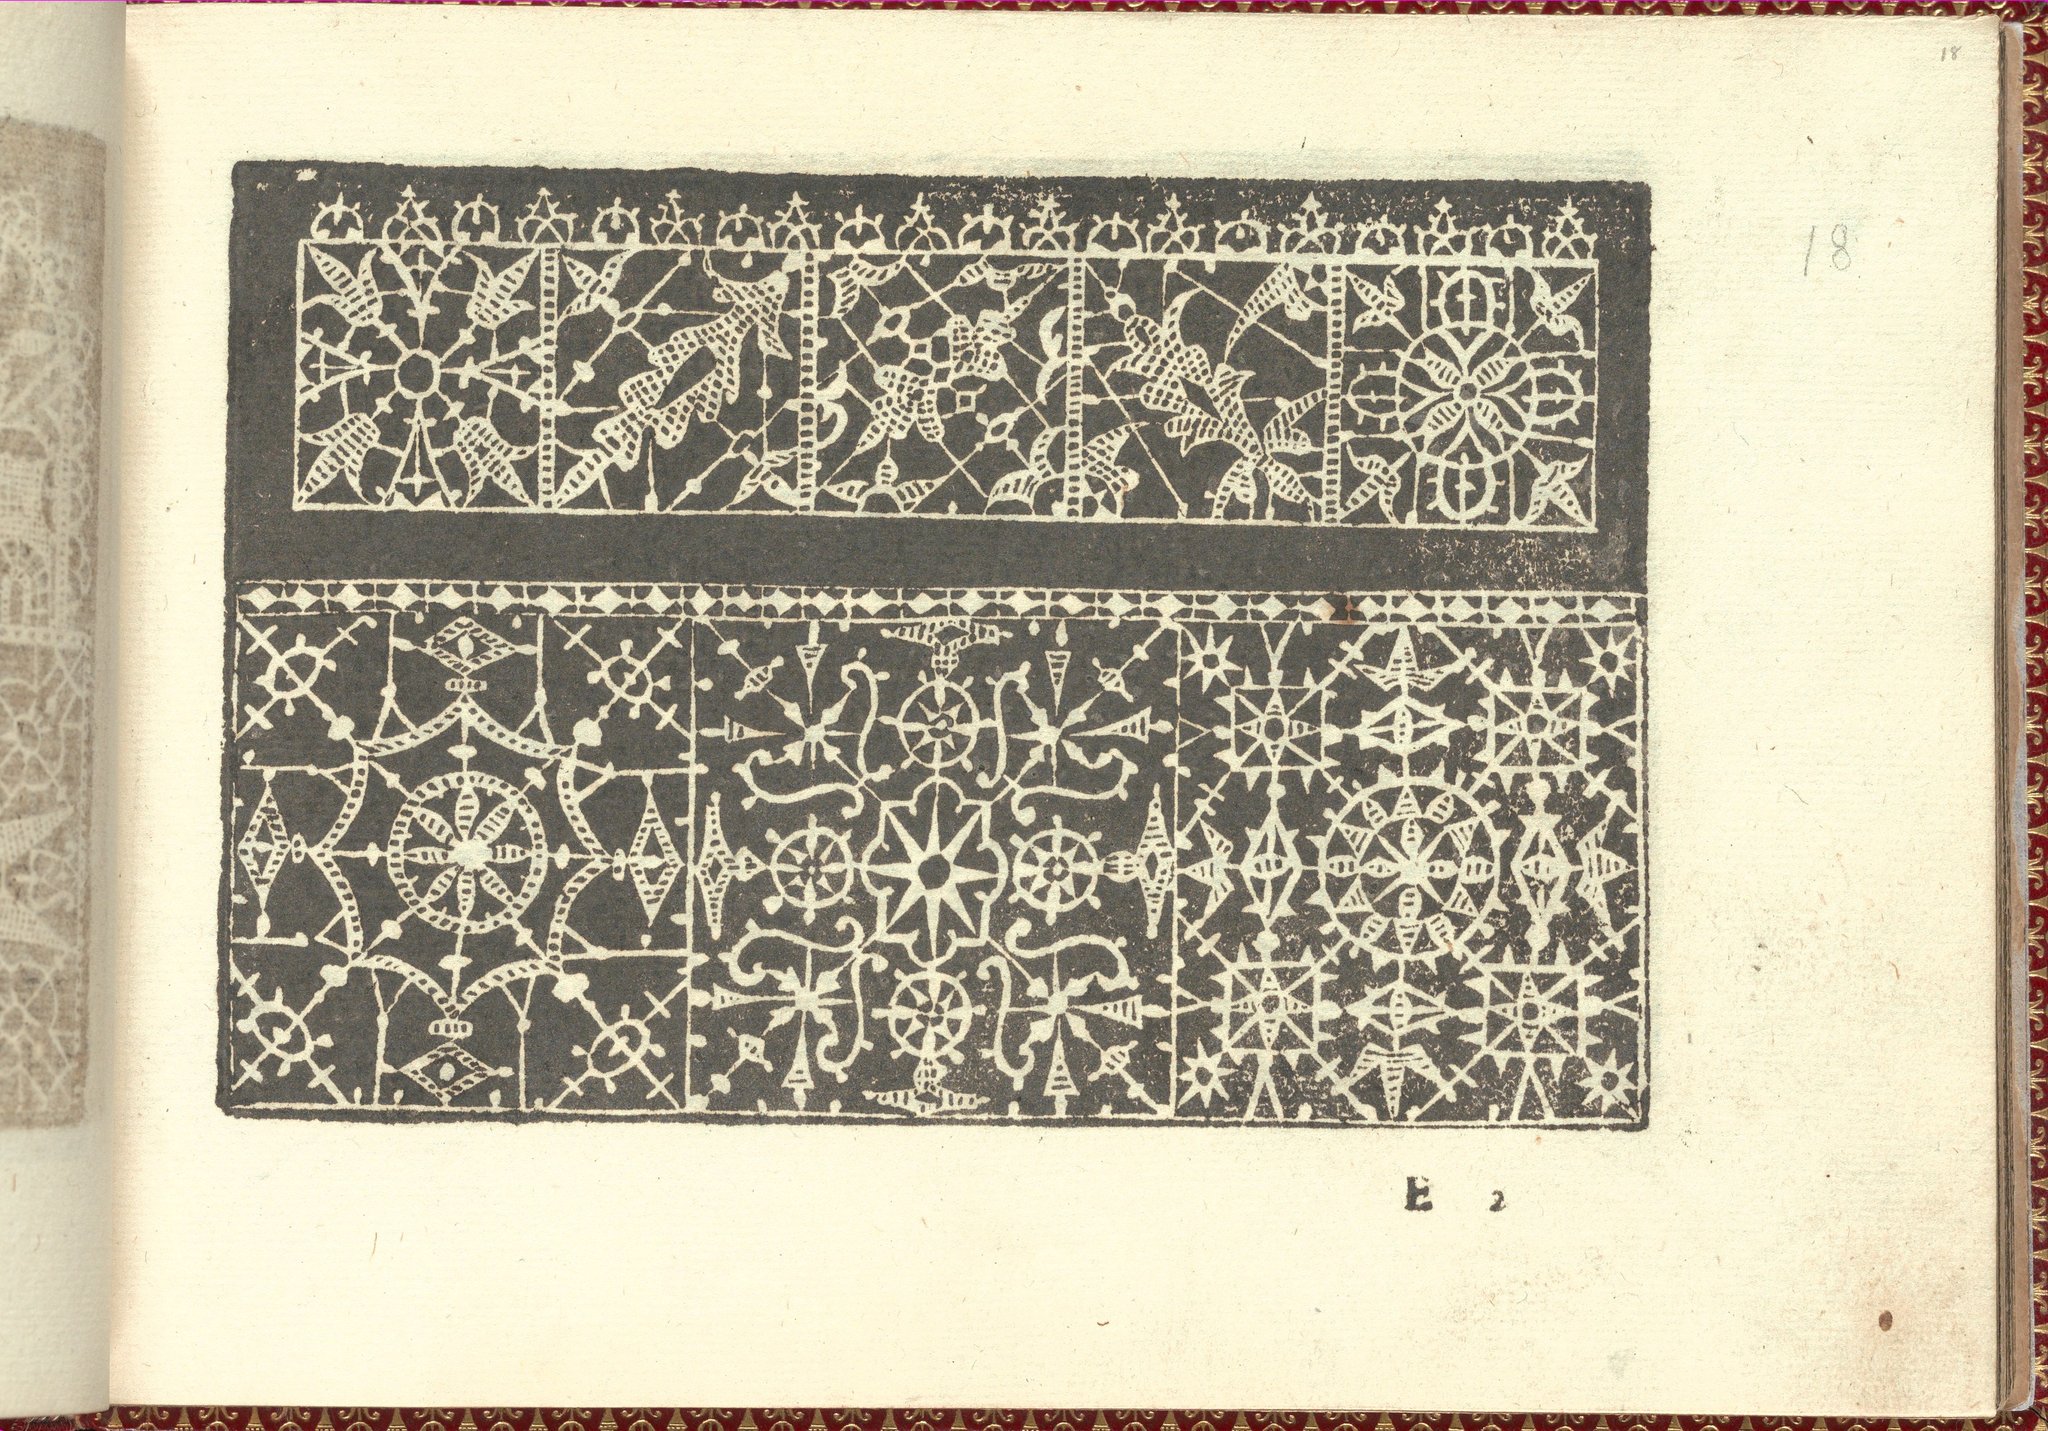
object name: book print ornament architecture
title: Corona delle Nobili et Virtuose Donne: Libro I-IV, page 18 (recto)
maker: cesare vecellio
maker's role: publisher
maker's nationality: italian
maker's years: 1521-1601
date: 1601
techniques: woodcut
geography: italy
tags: ornament